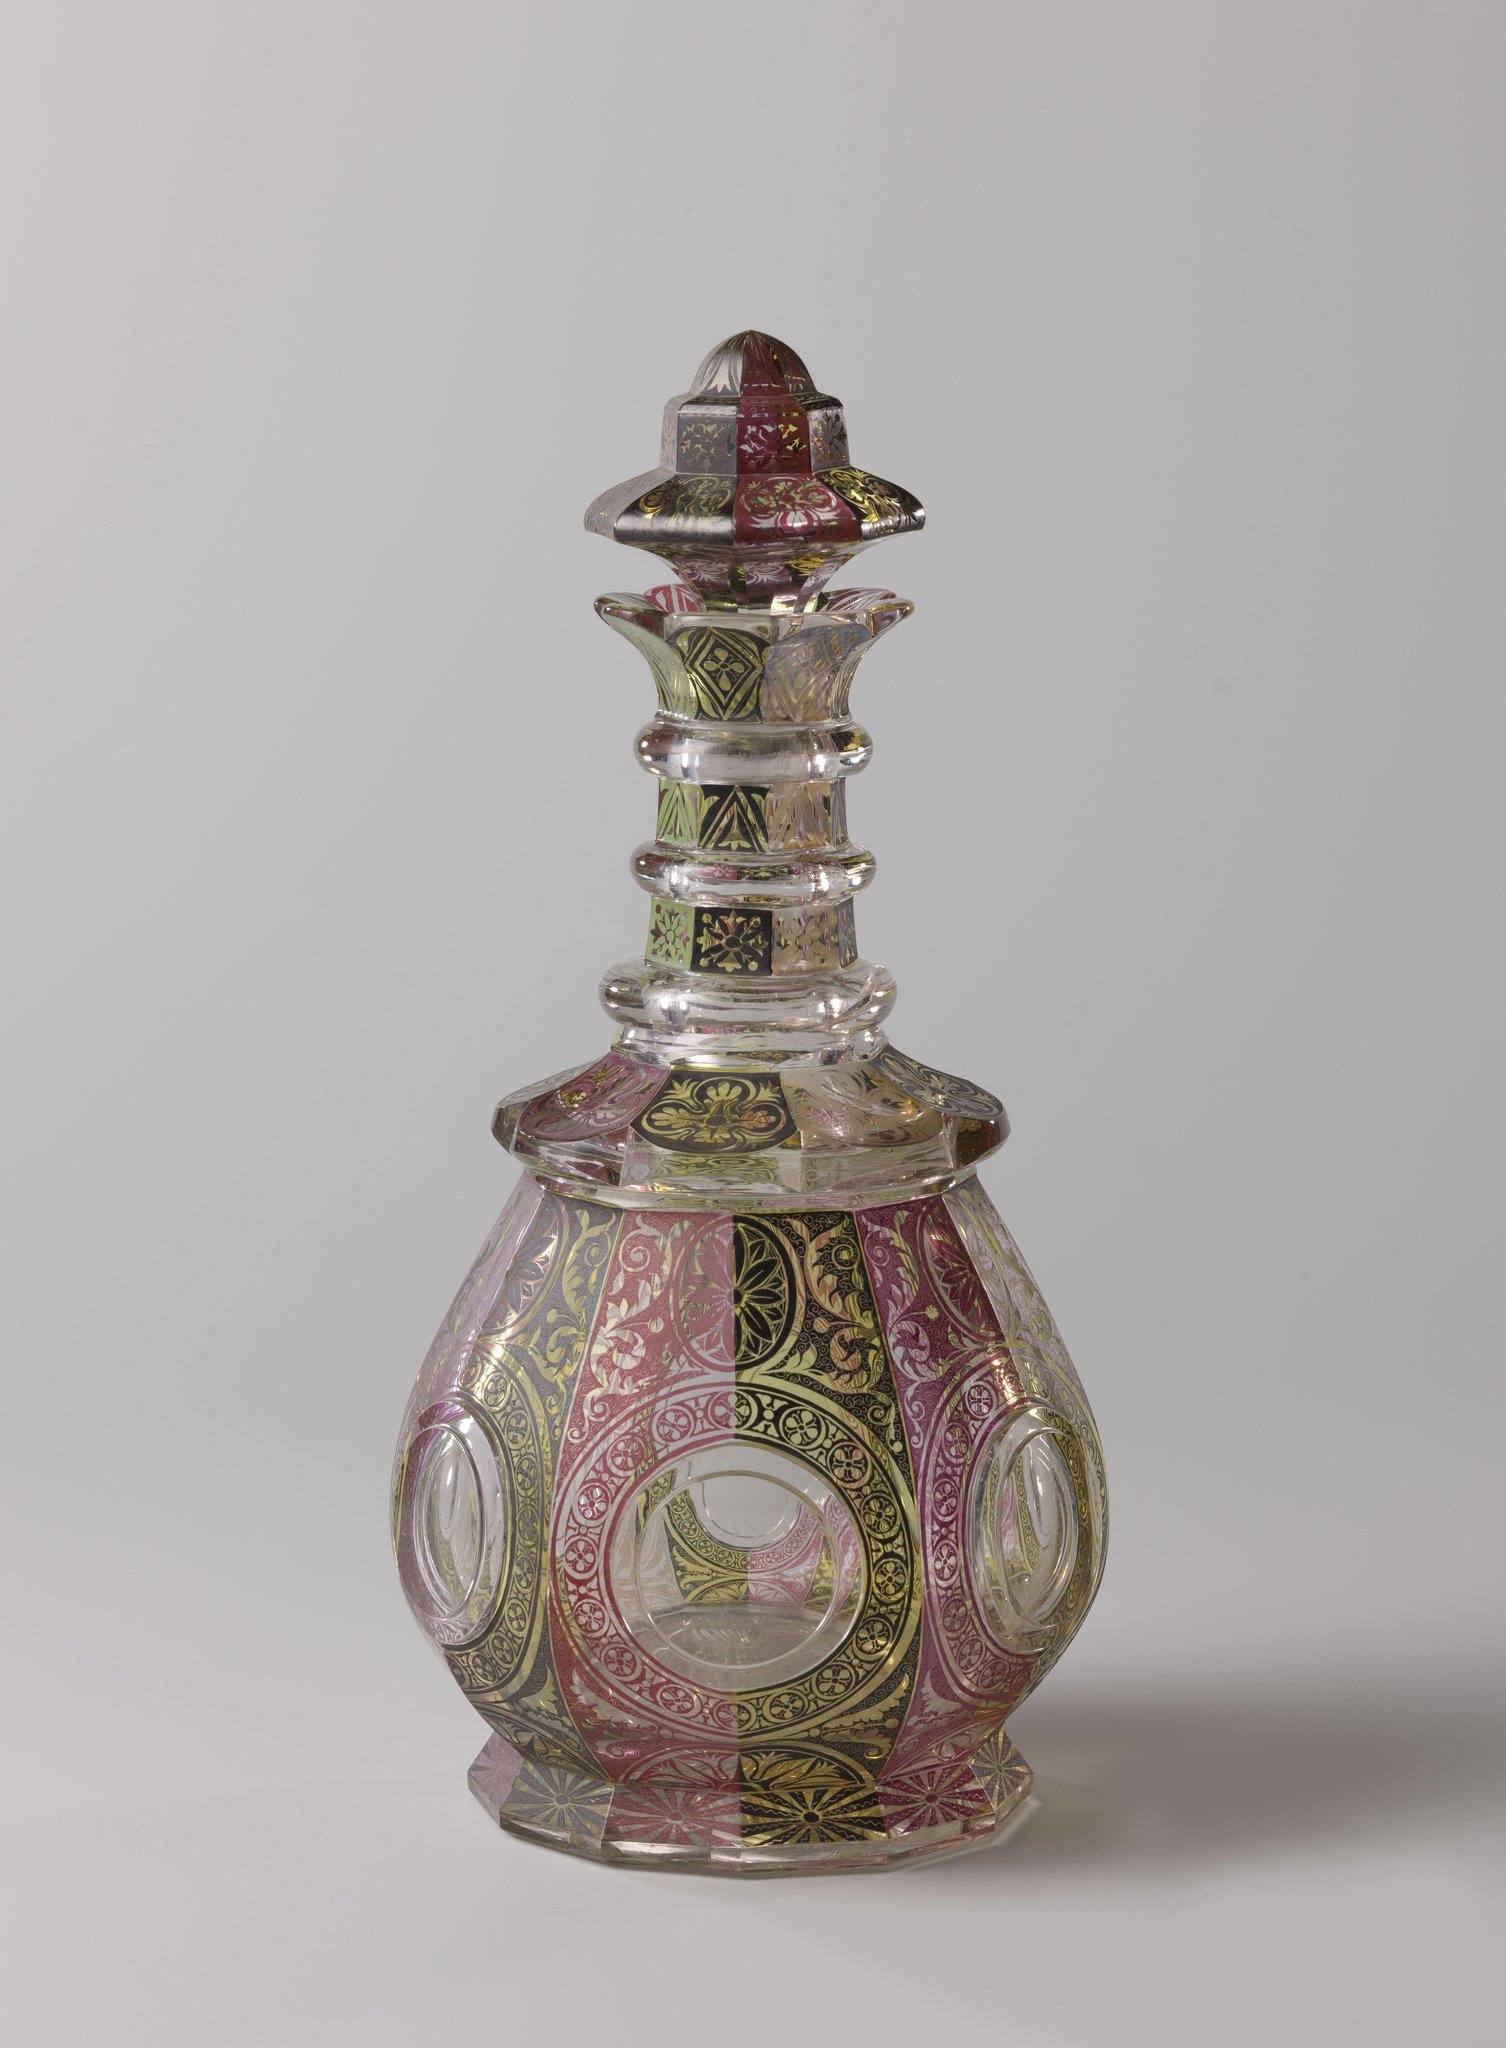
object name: carafe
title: Karaf met neorenaissancistische en neogotische ornamenten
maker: Anonymous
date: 1850-1900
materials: glass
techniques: glassblowing, grinding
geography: europe